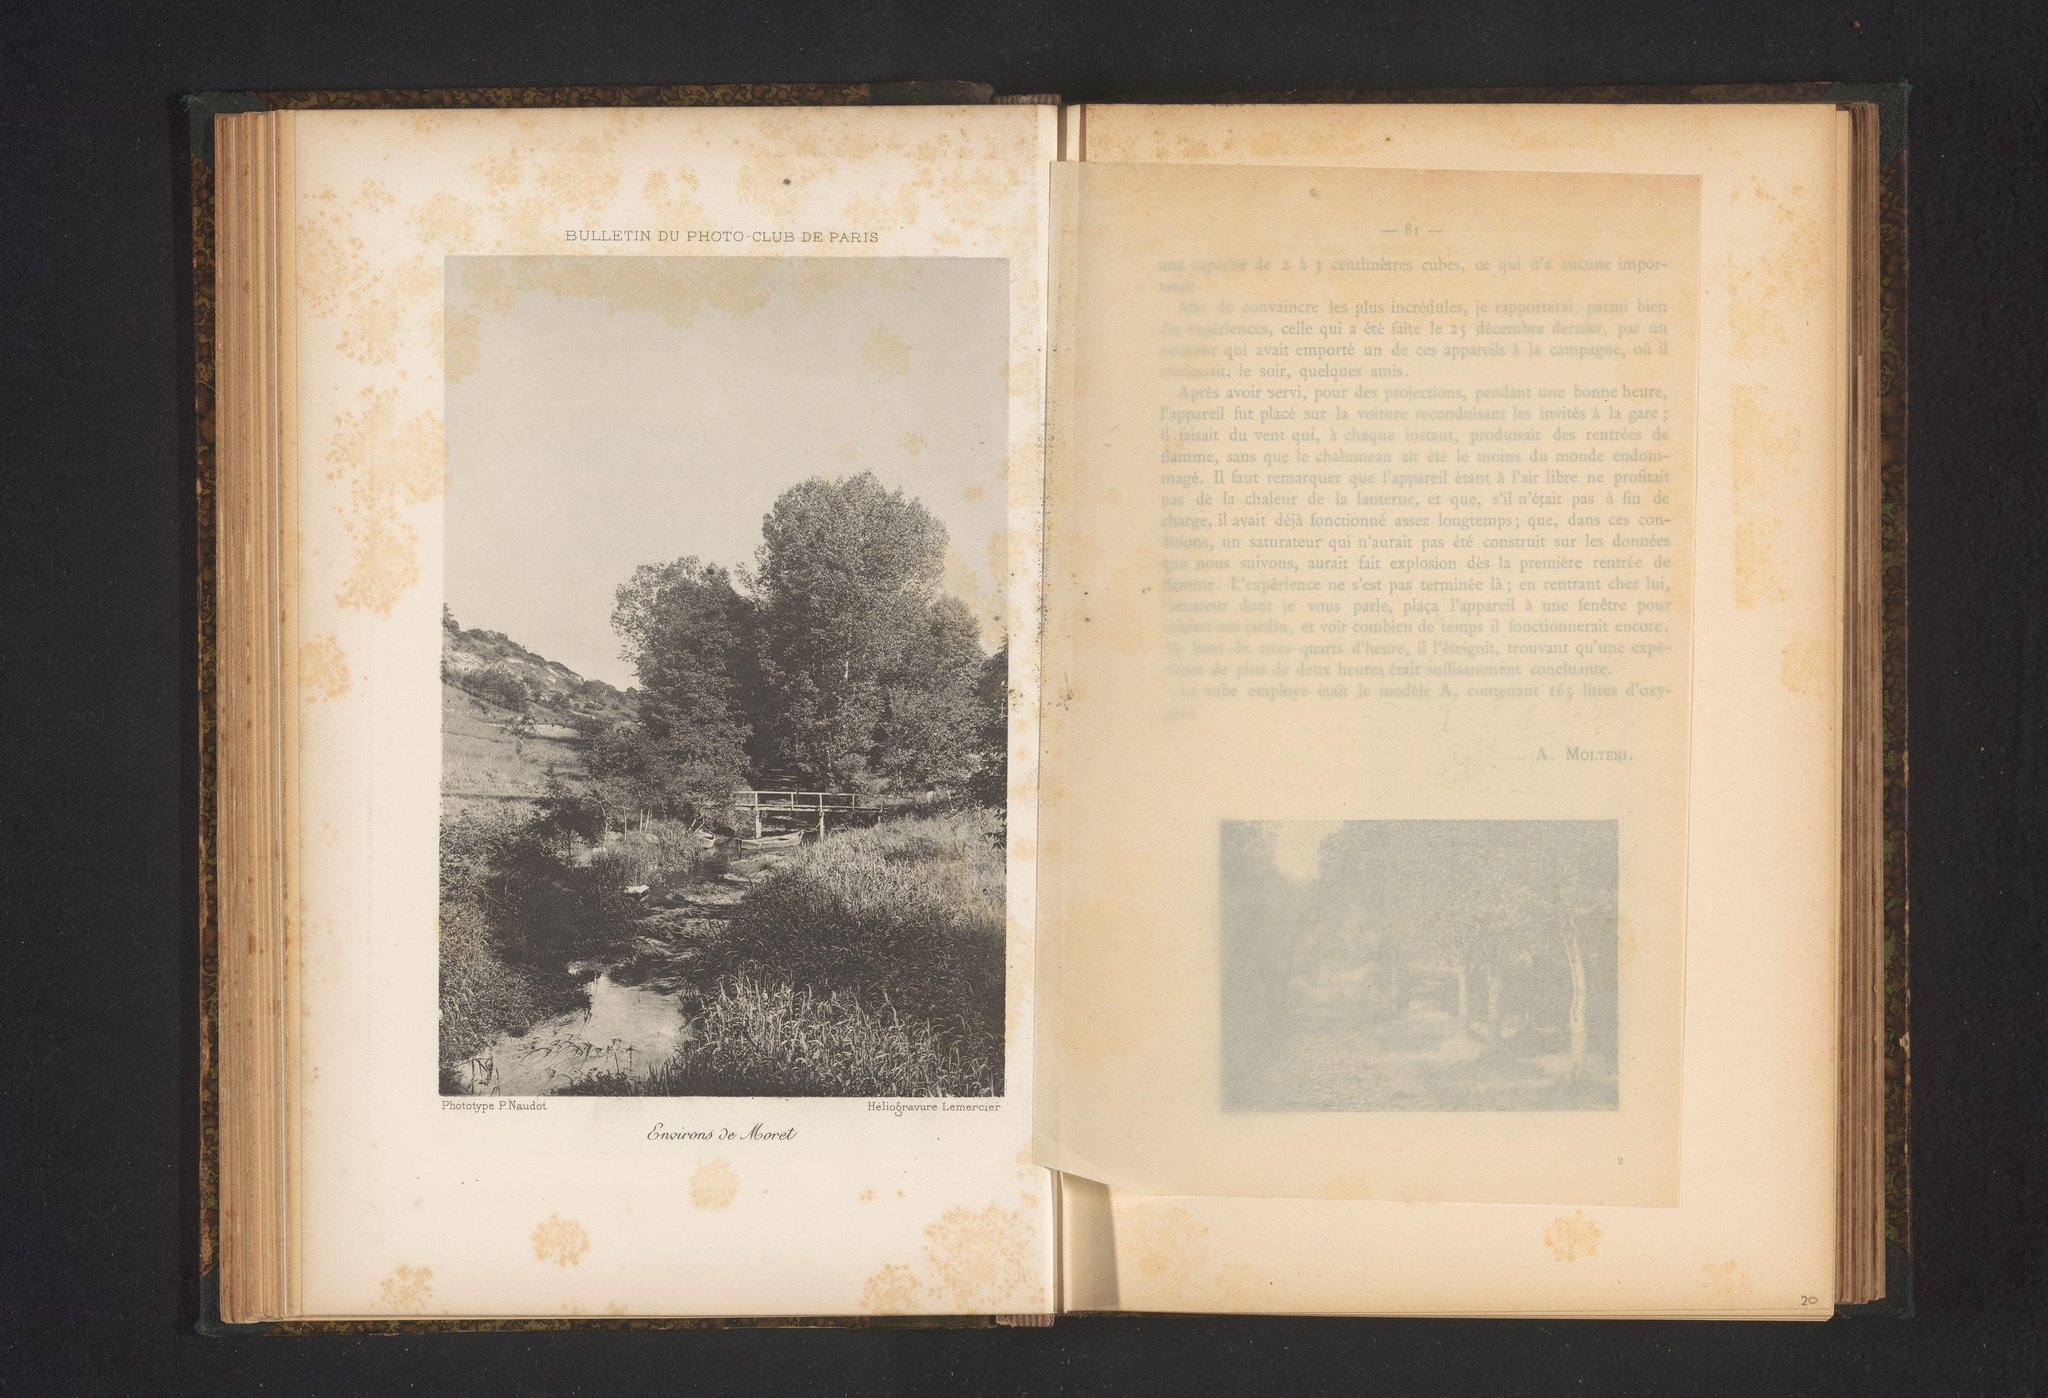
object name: page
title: Environs de Moret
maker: paul naudot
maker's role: fotograaf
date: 1890-1895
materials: paper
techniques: photoaquatint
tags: landscapes, brook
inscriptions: inscription: ‘Bulletin du Photo-Club de Paris’